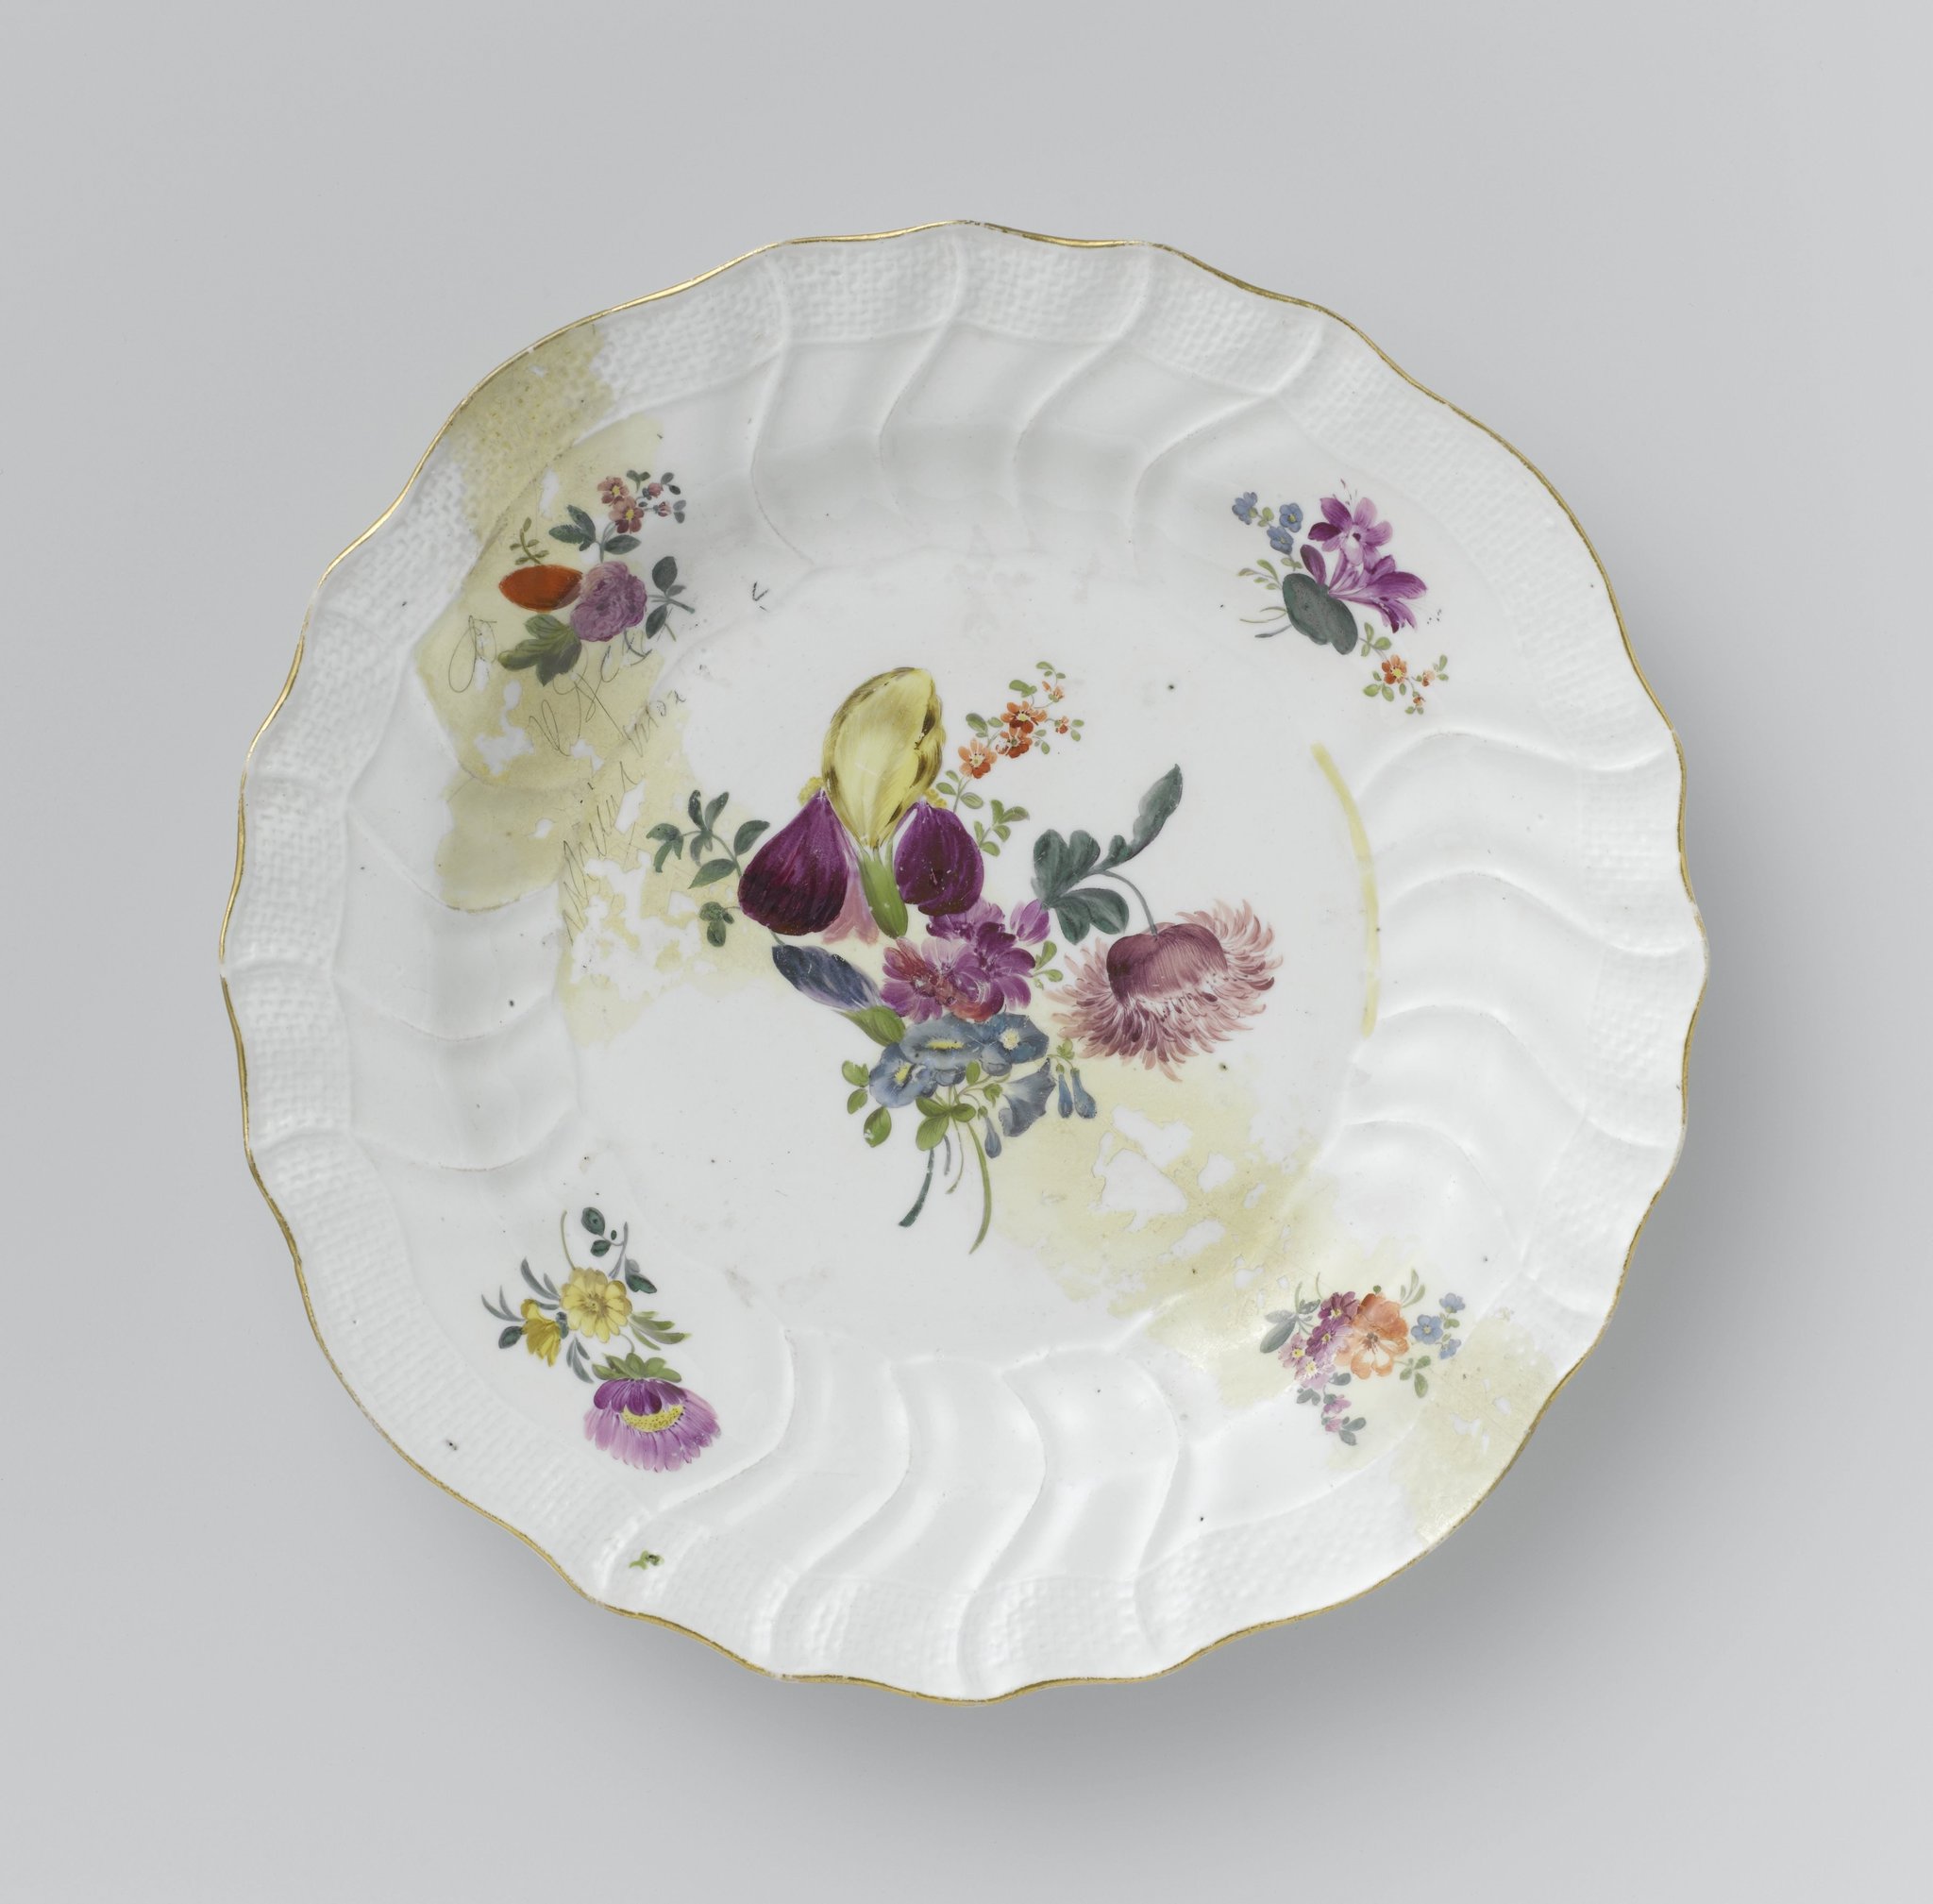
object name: eating drinking utensil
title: Bord, veelkleurig beschilderd met Deutsche Blumen, insekten en vruchten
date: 1750-1760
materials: porcelain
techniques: painted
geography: meissen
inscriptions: factory mark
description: Rond bord van beschilderd porselein. De rand is versierd met het Neuozier-patroon. De beschildering bestaat uit Deutsche Blumen, insekten en vruchten. Het bord is gemerkt en hoort bij een servies (BK-17474-1 t/m BK-17474-253).